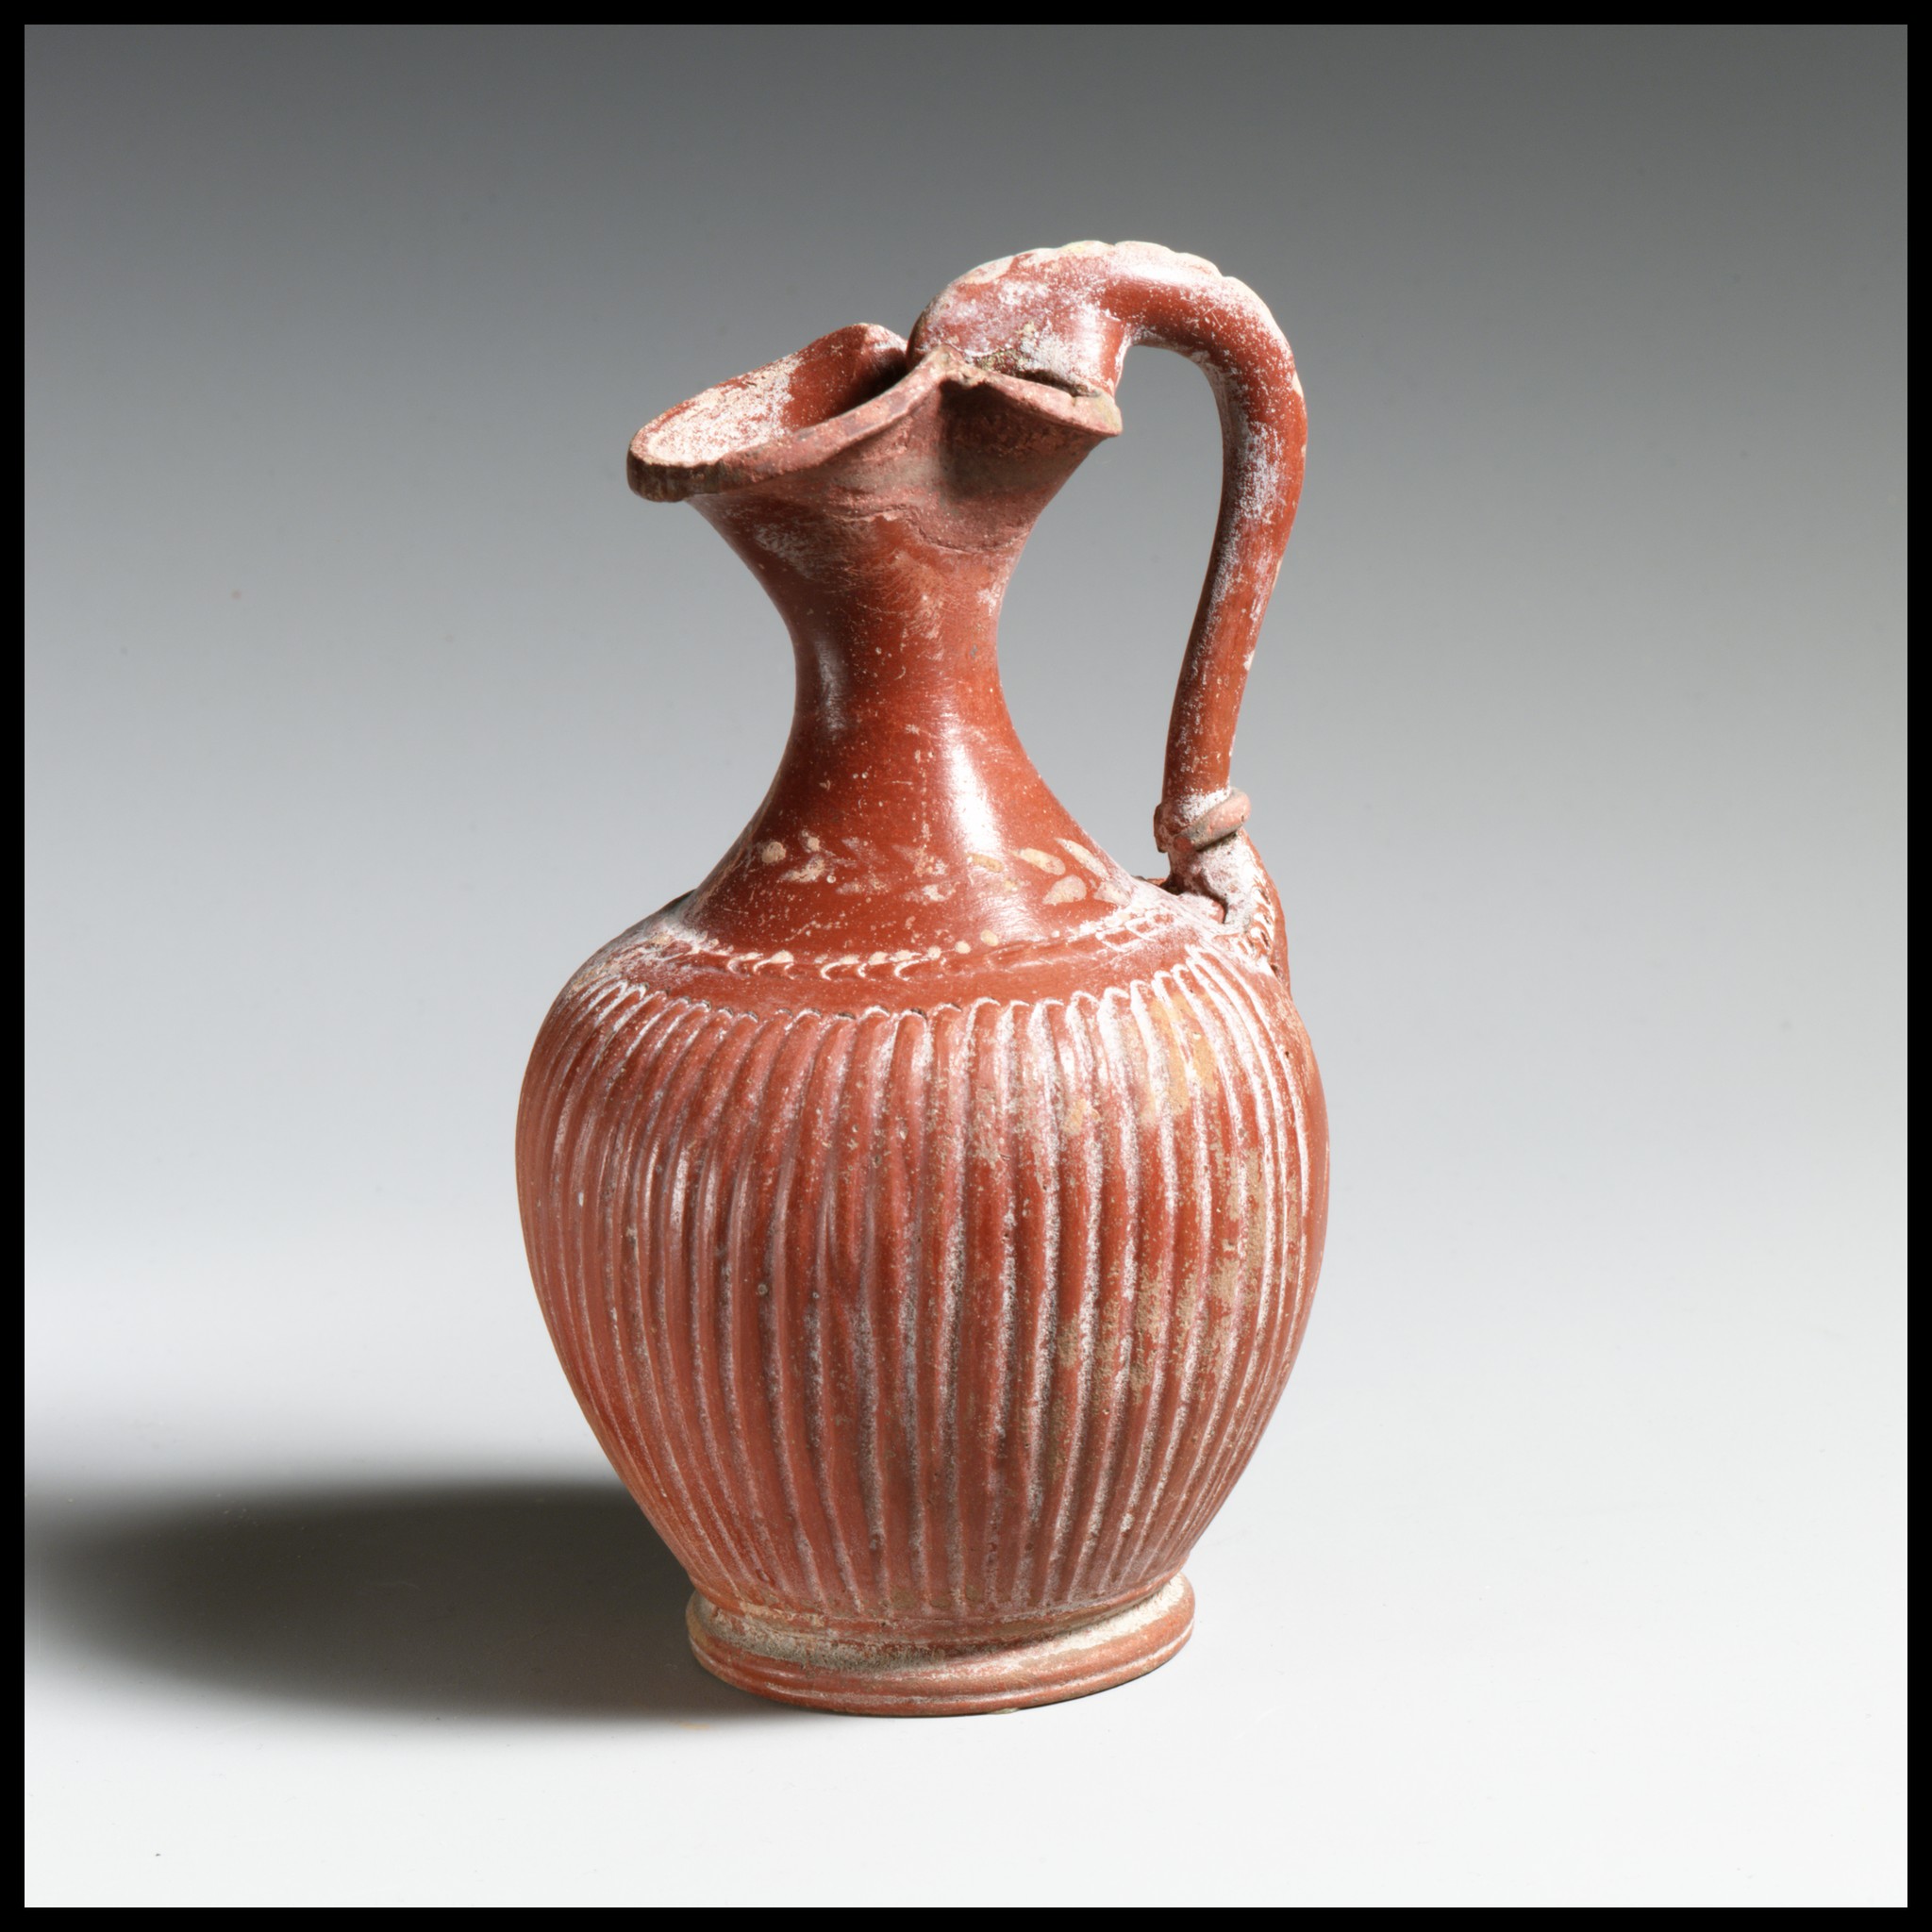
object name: oinochoe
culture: greek, south italian, apulian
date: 300-201 BCE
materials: terracotta